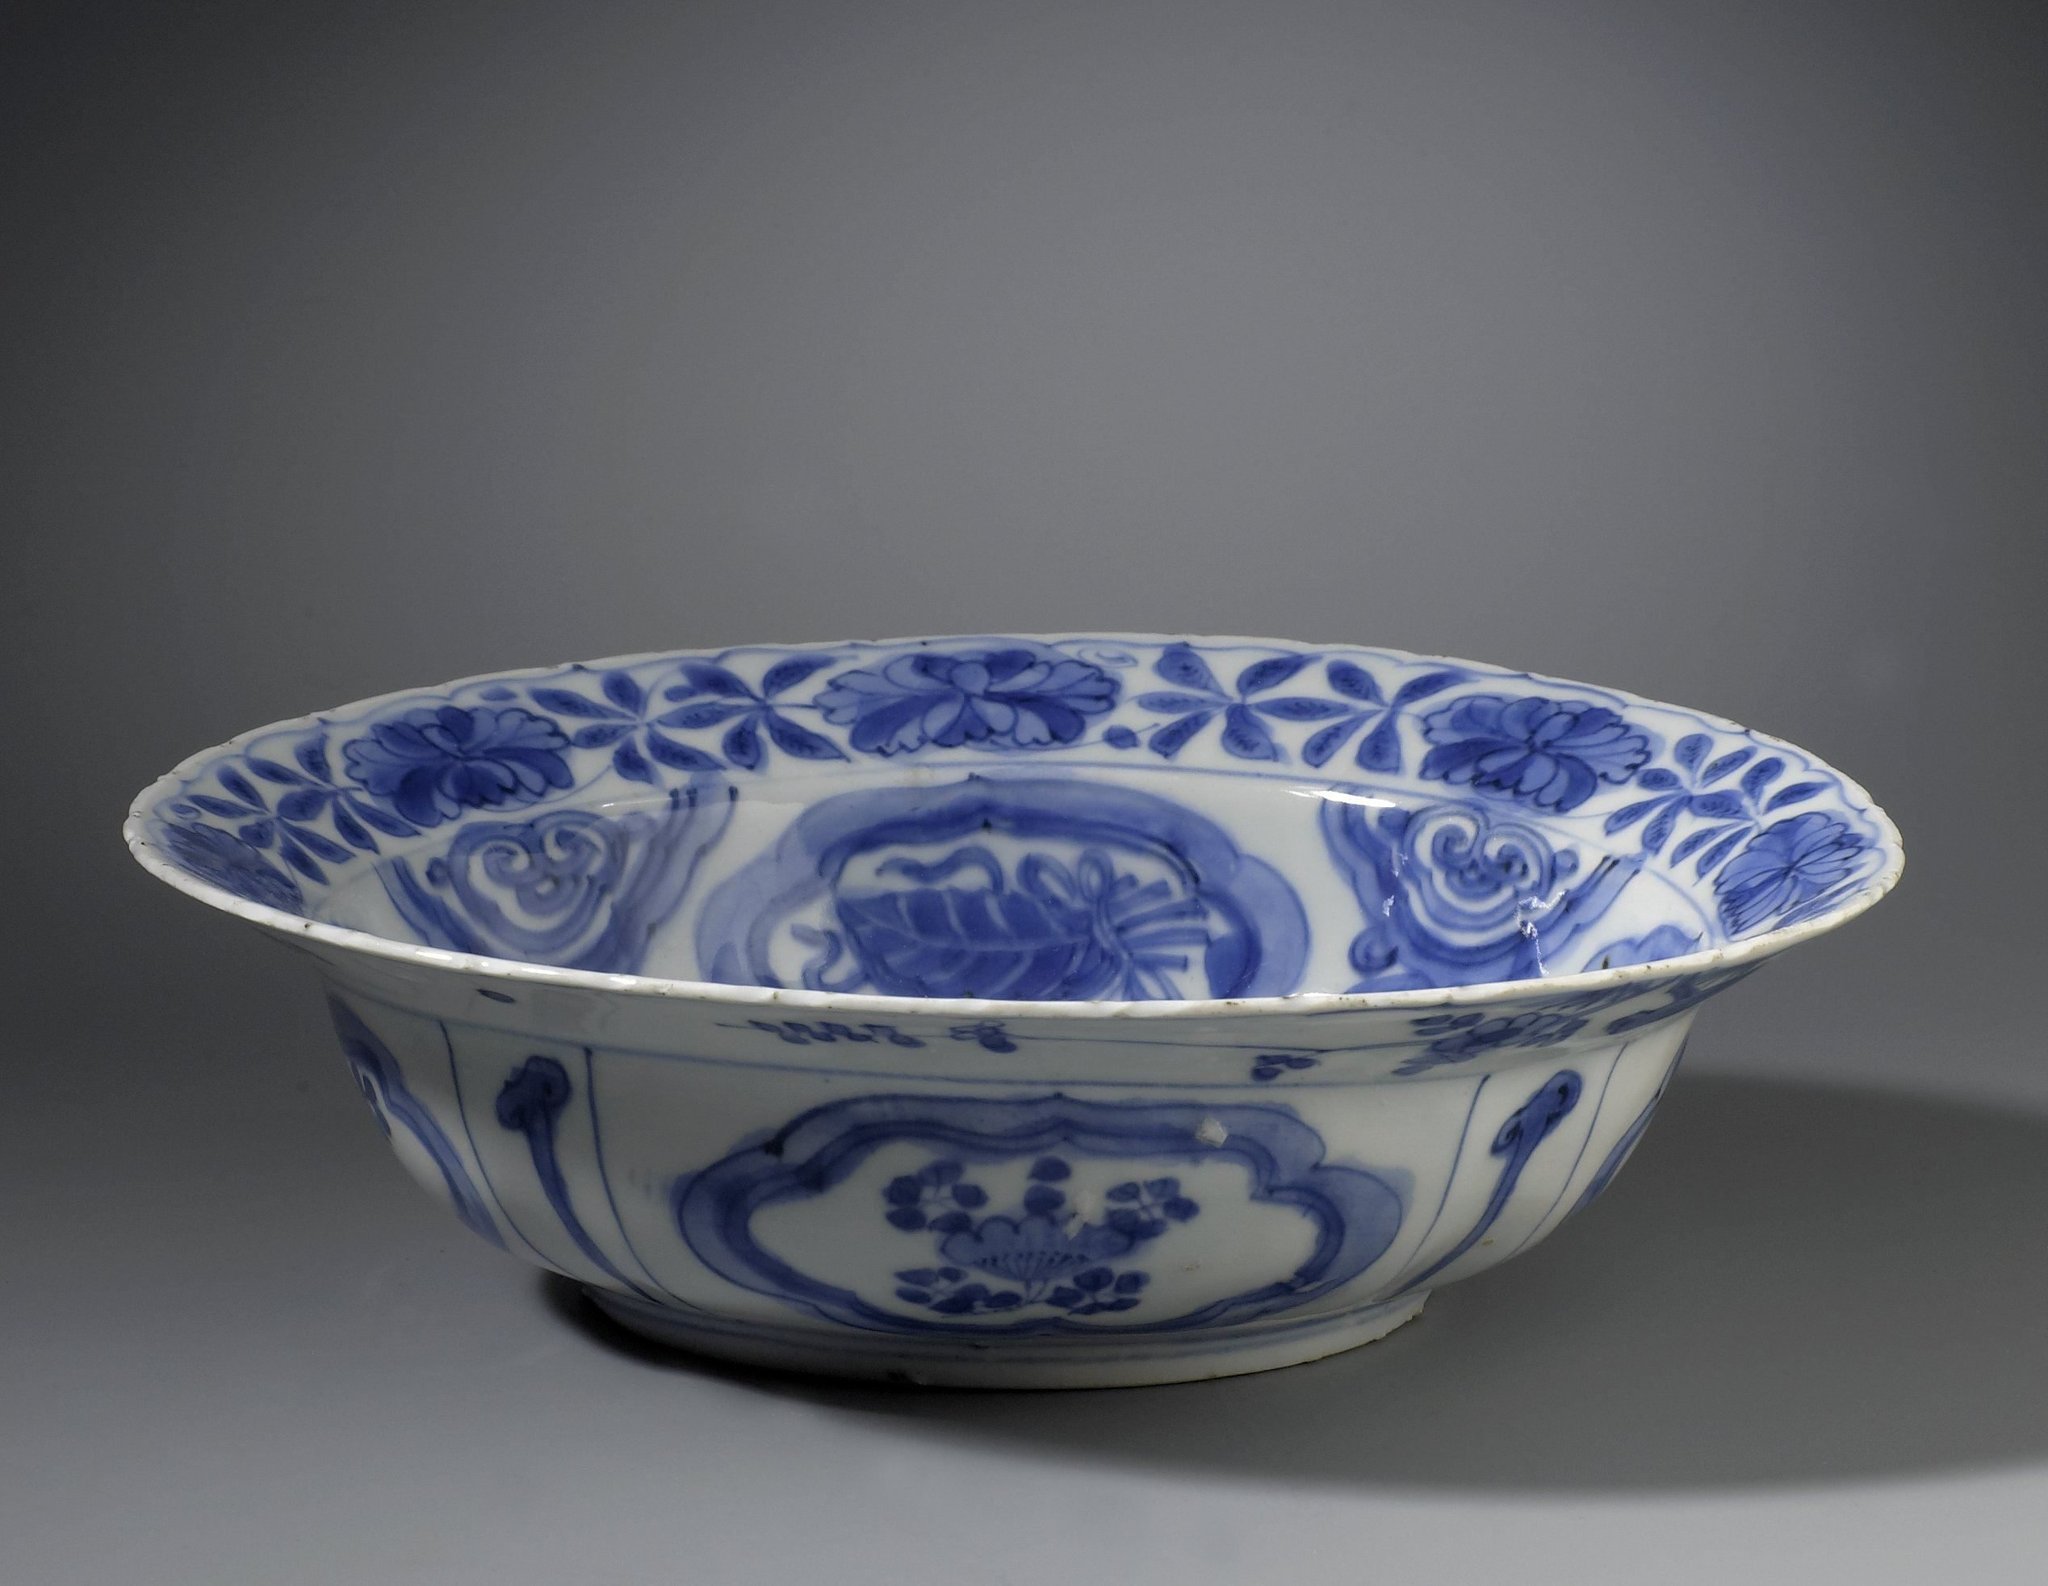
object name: bowl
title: Klapmuts bowl with two figures in a water landscape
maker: Anonymous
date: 1600-1624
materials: cobalt, glaze, paint, porcelain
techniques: firing, turning, vitrification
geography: china